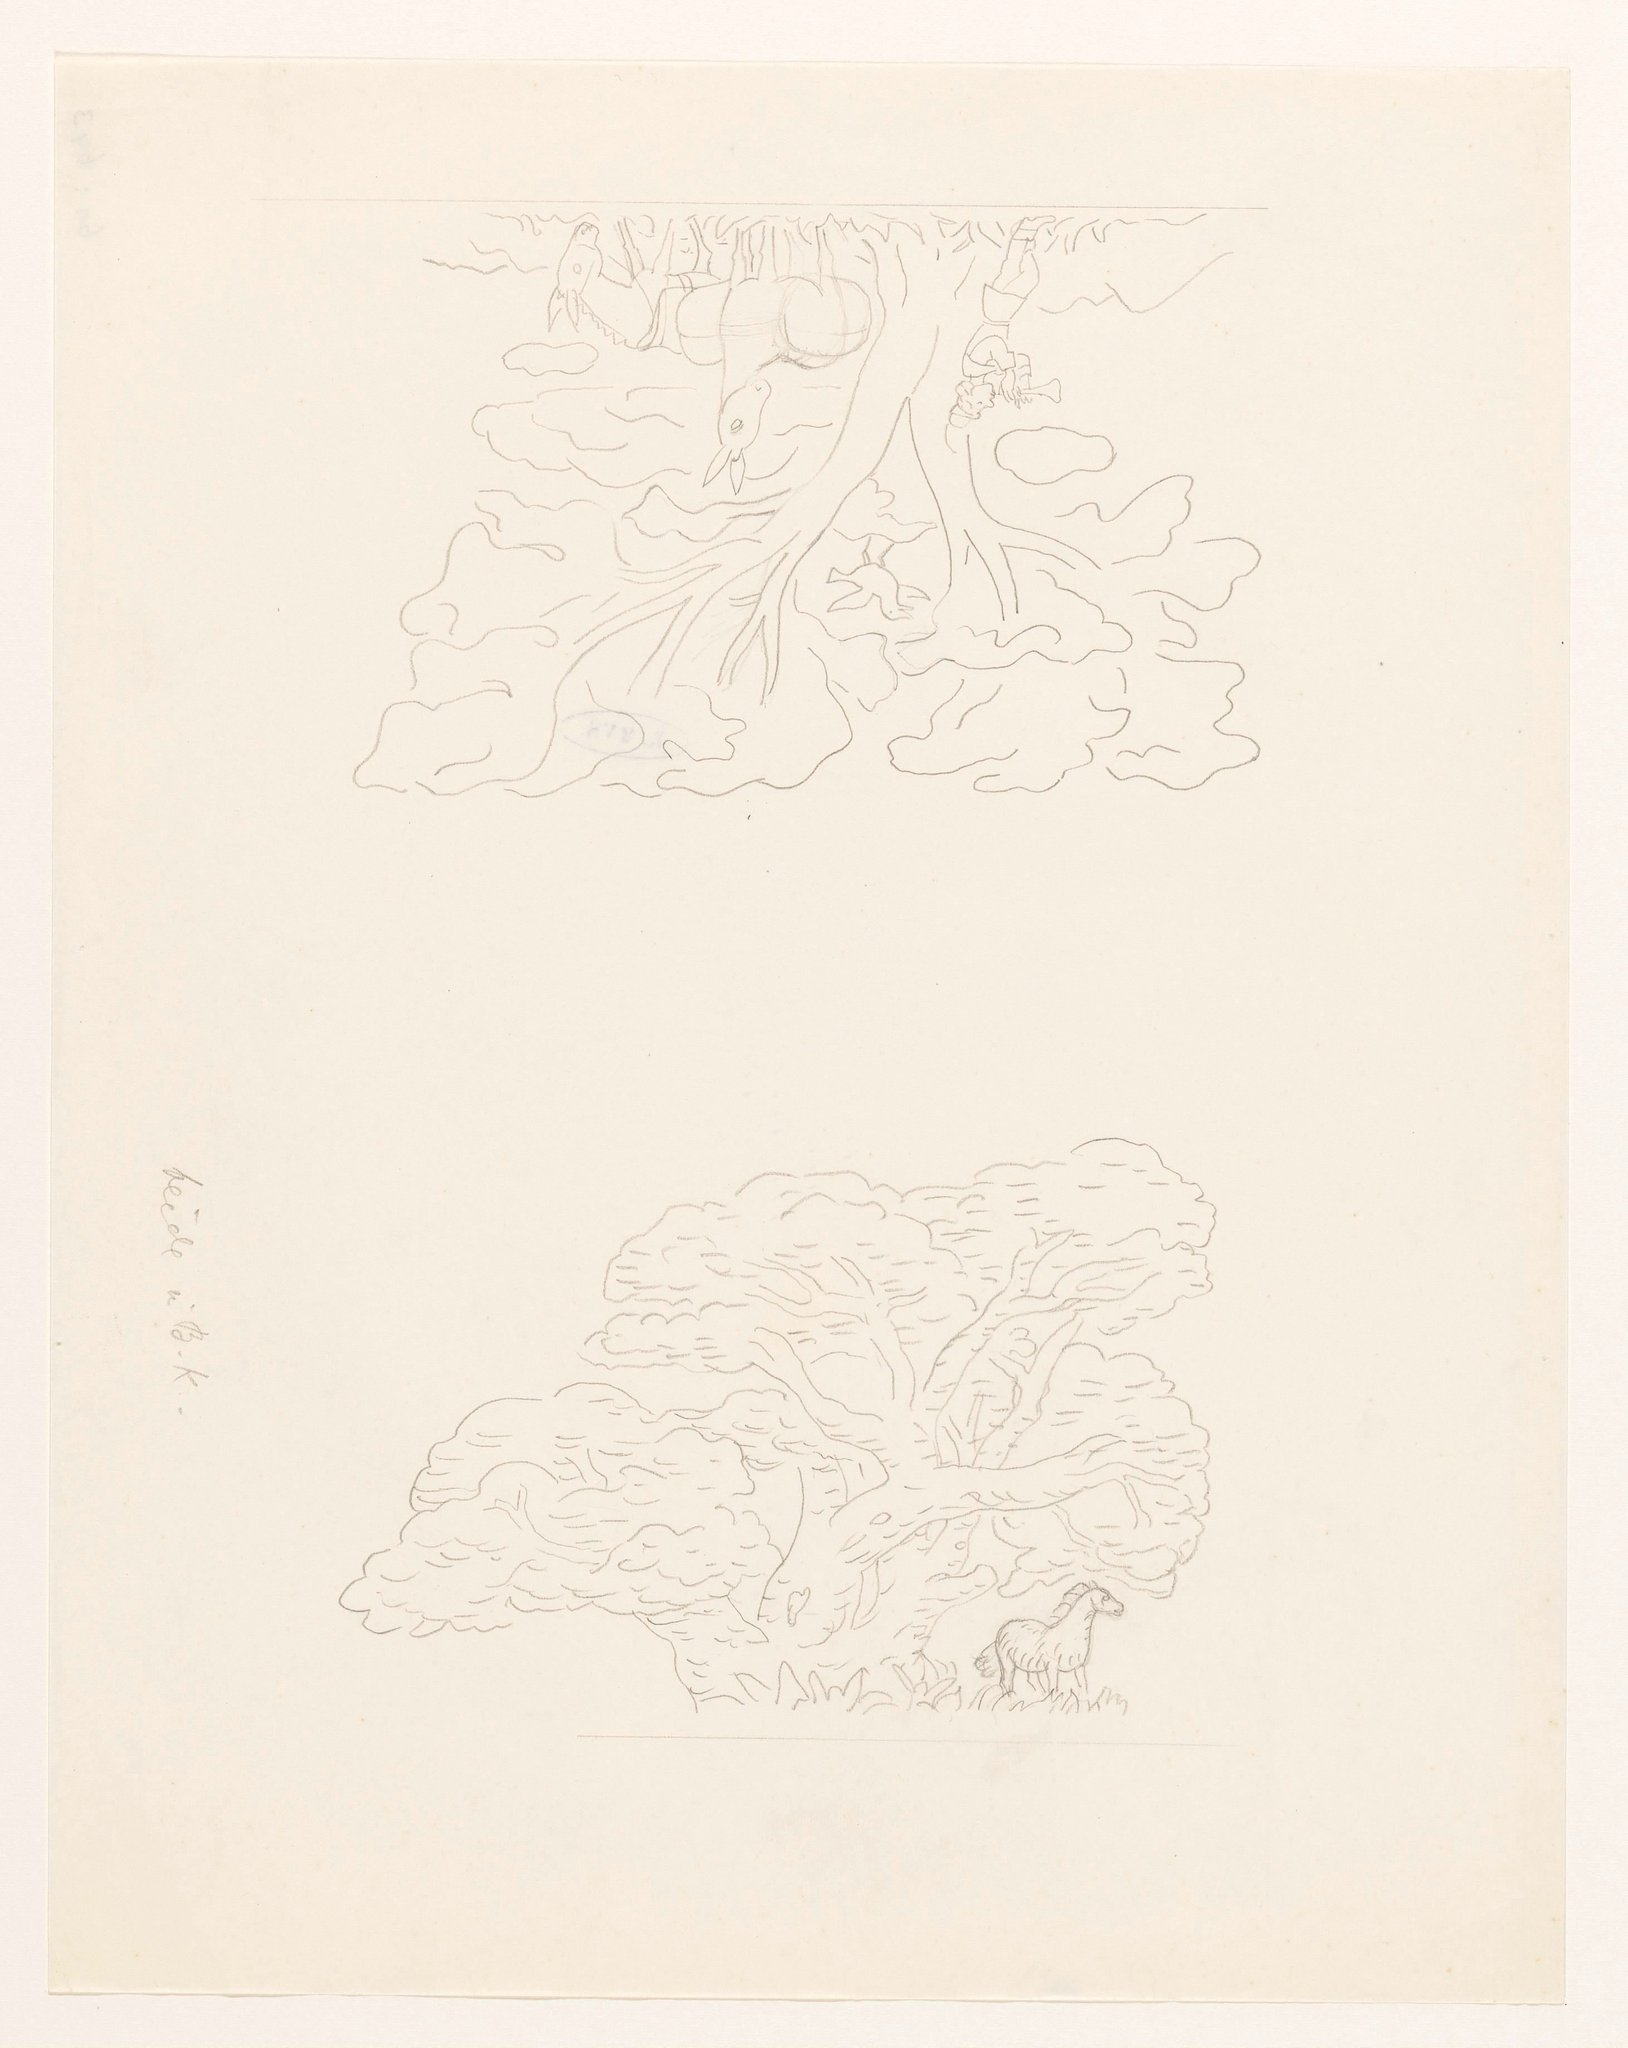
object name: drawing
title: Studieblad met paard onder een boom en een man spelend op een trompet onder een boom, vergezeld door twee ezels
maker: leo gestel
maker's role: draughtsman, print maker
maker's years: 1881-1941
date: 1891-1941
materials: paper, pencil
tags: trees, ass, donkey, horn, trumpet, cornet, trombone, tuba, horse, male sex; man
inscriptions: :, watermark: ‘GW/ PAPIER/ 1671’, collector's mark: Lugt 2228